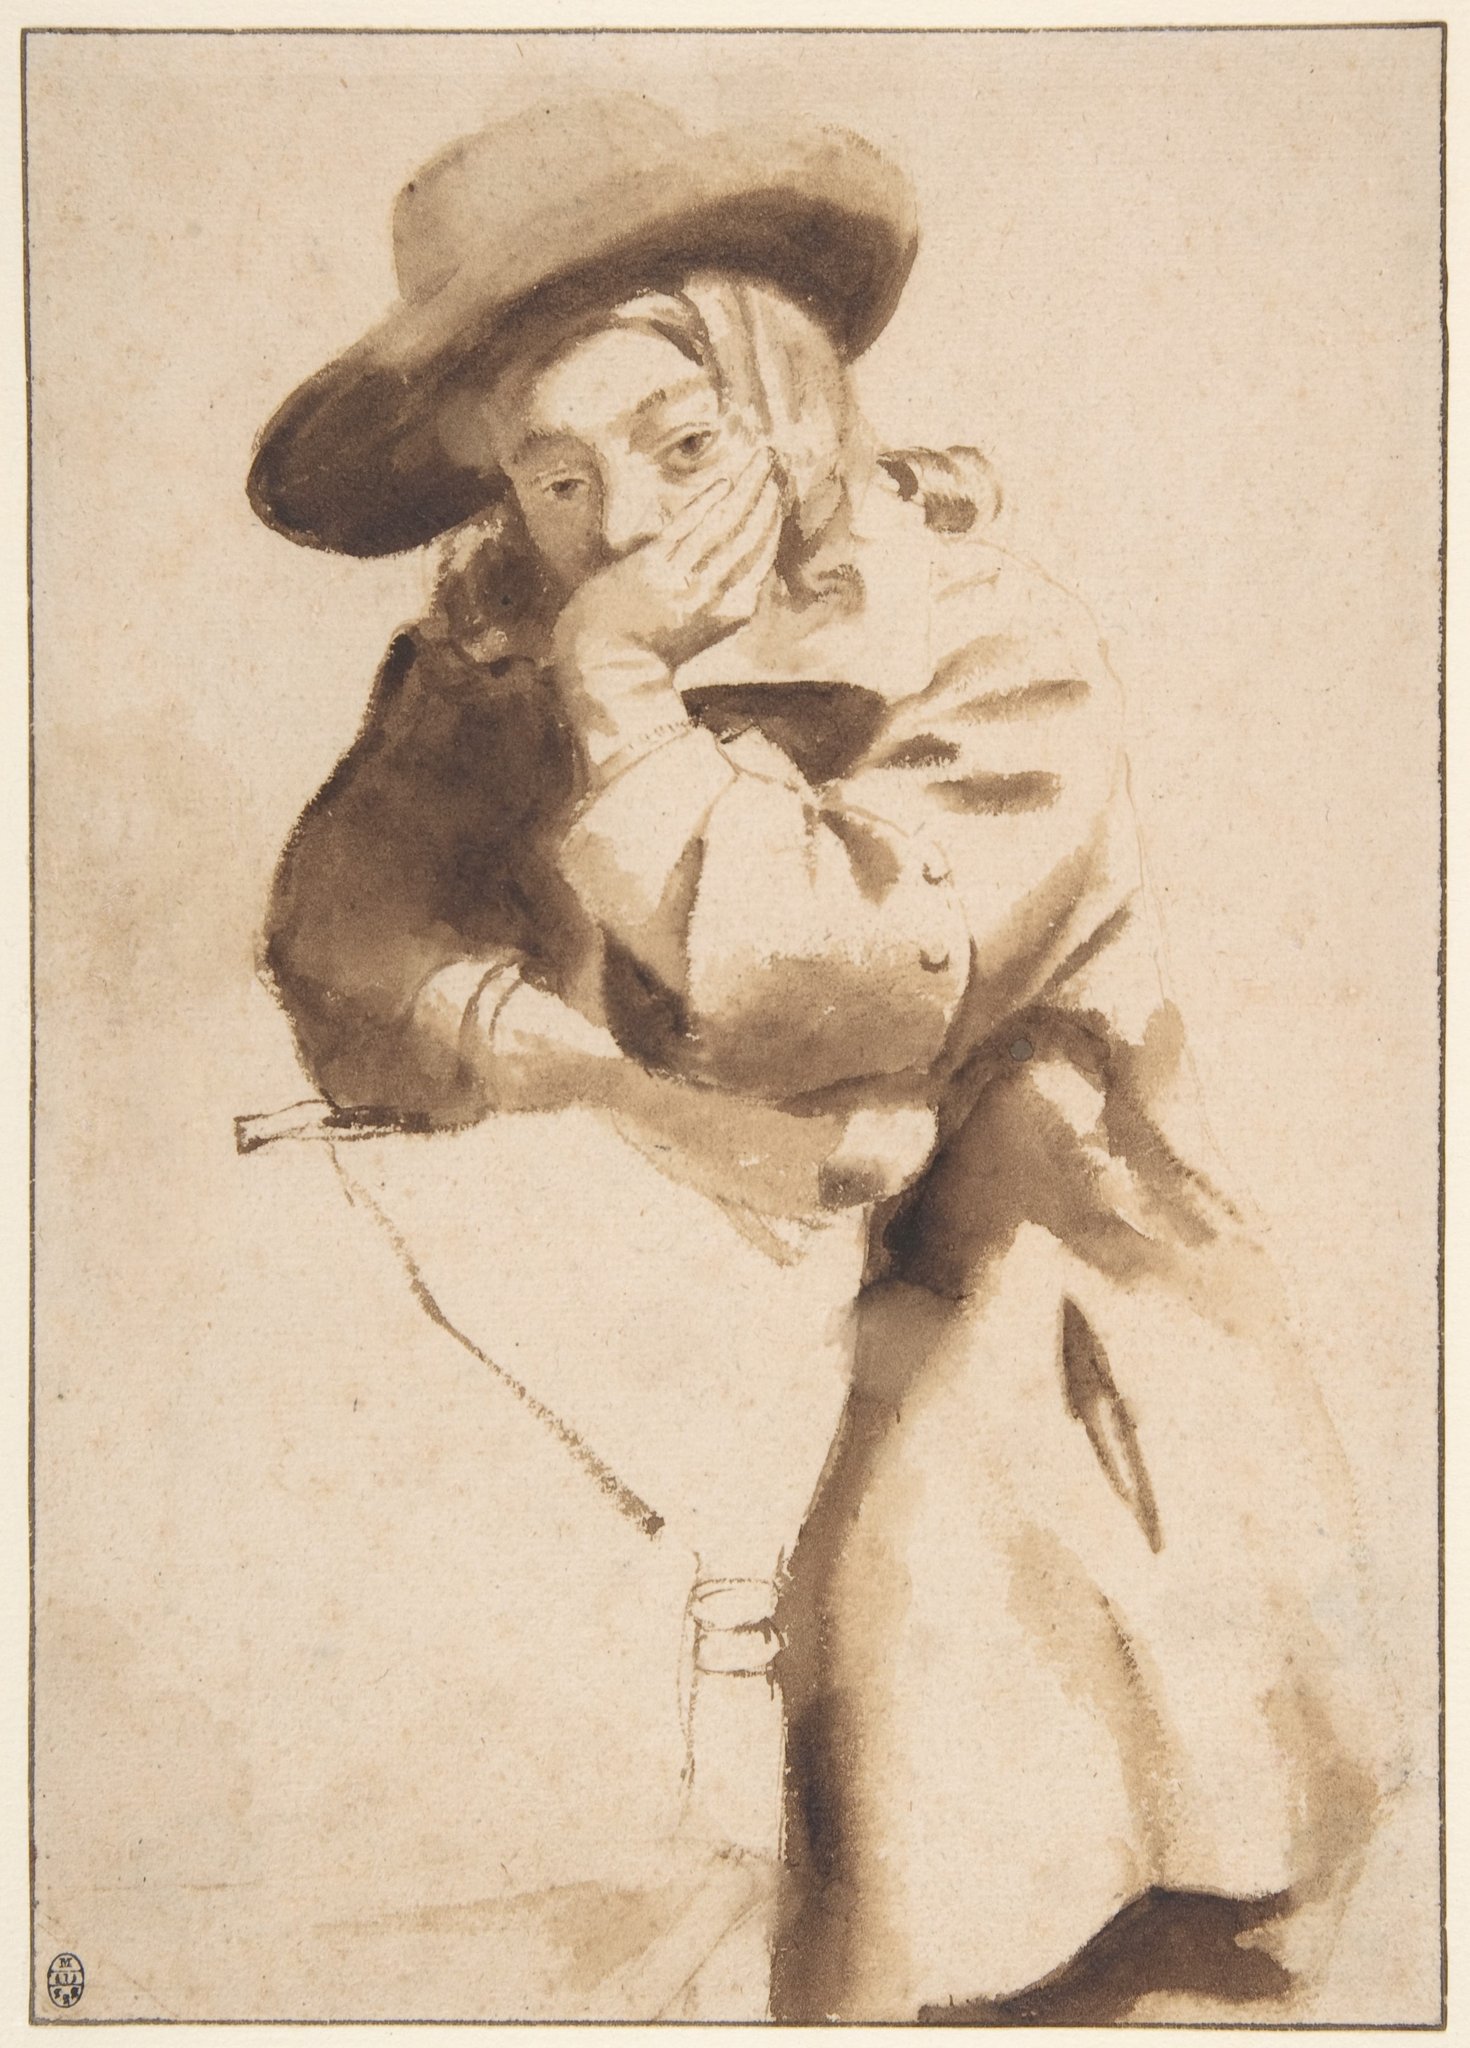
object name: drawing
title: Young Man in Broad-Brimmed Hat, Resting His Chin on His Left Hand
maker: gerbrand van den eeckhout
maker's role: artist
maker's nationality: dutch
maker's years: 1621-1674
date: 1655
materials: ink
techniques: brush, pen, wash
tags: contemplation,men